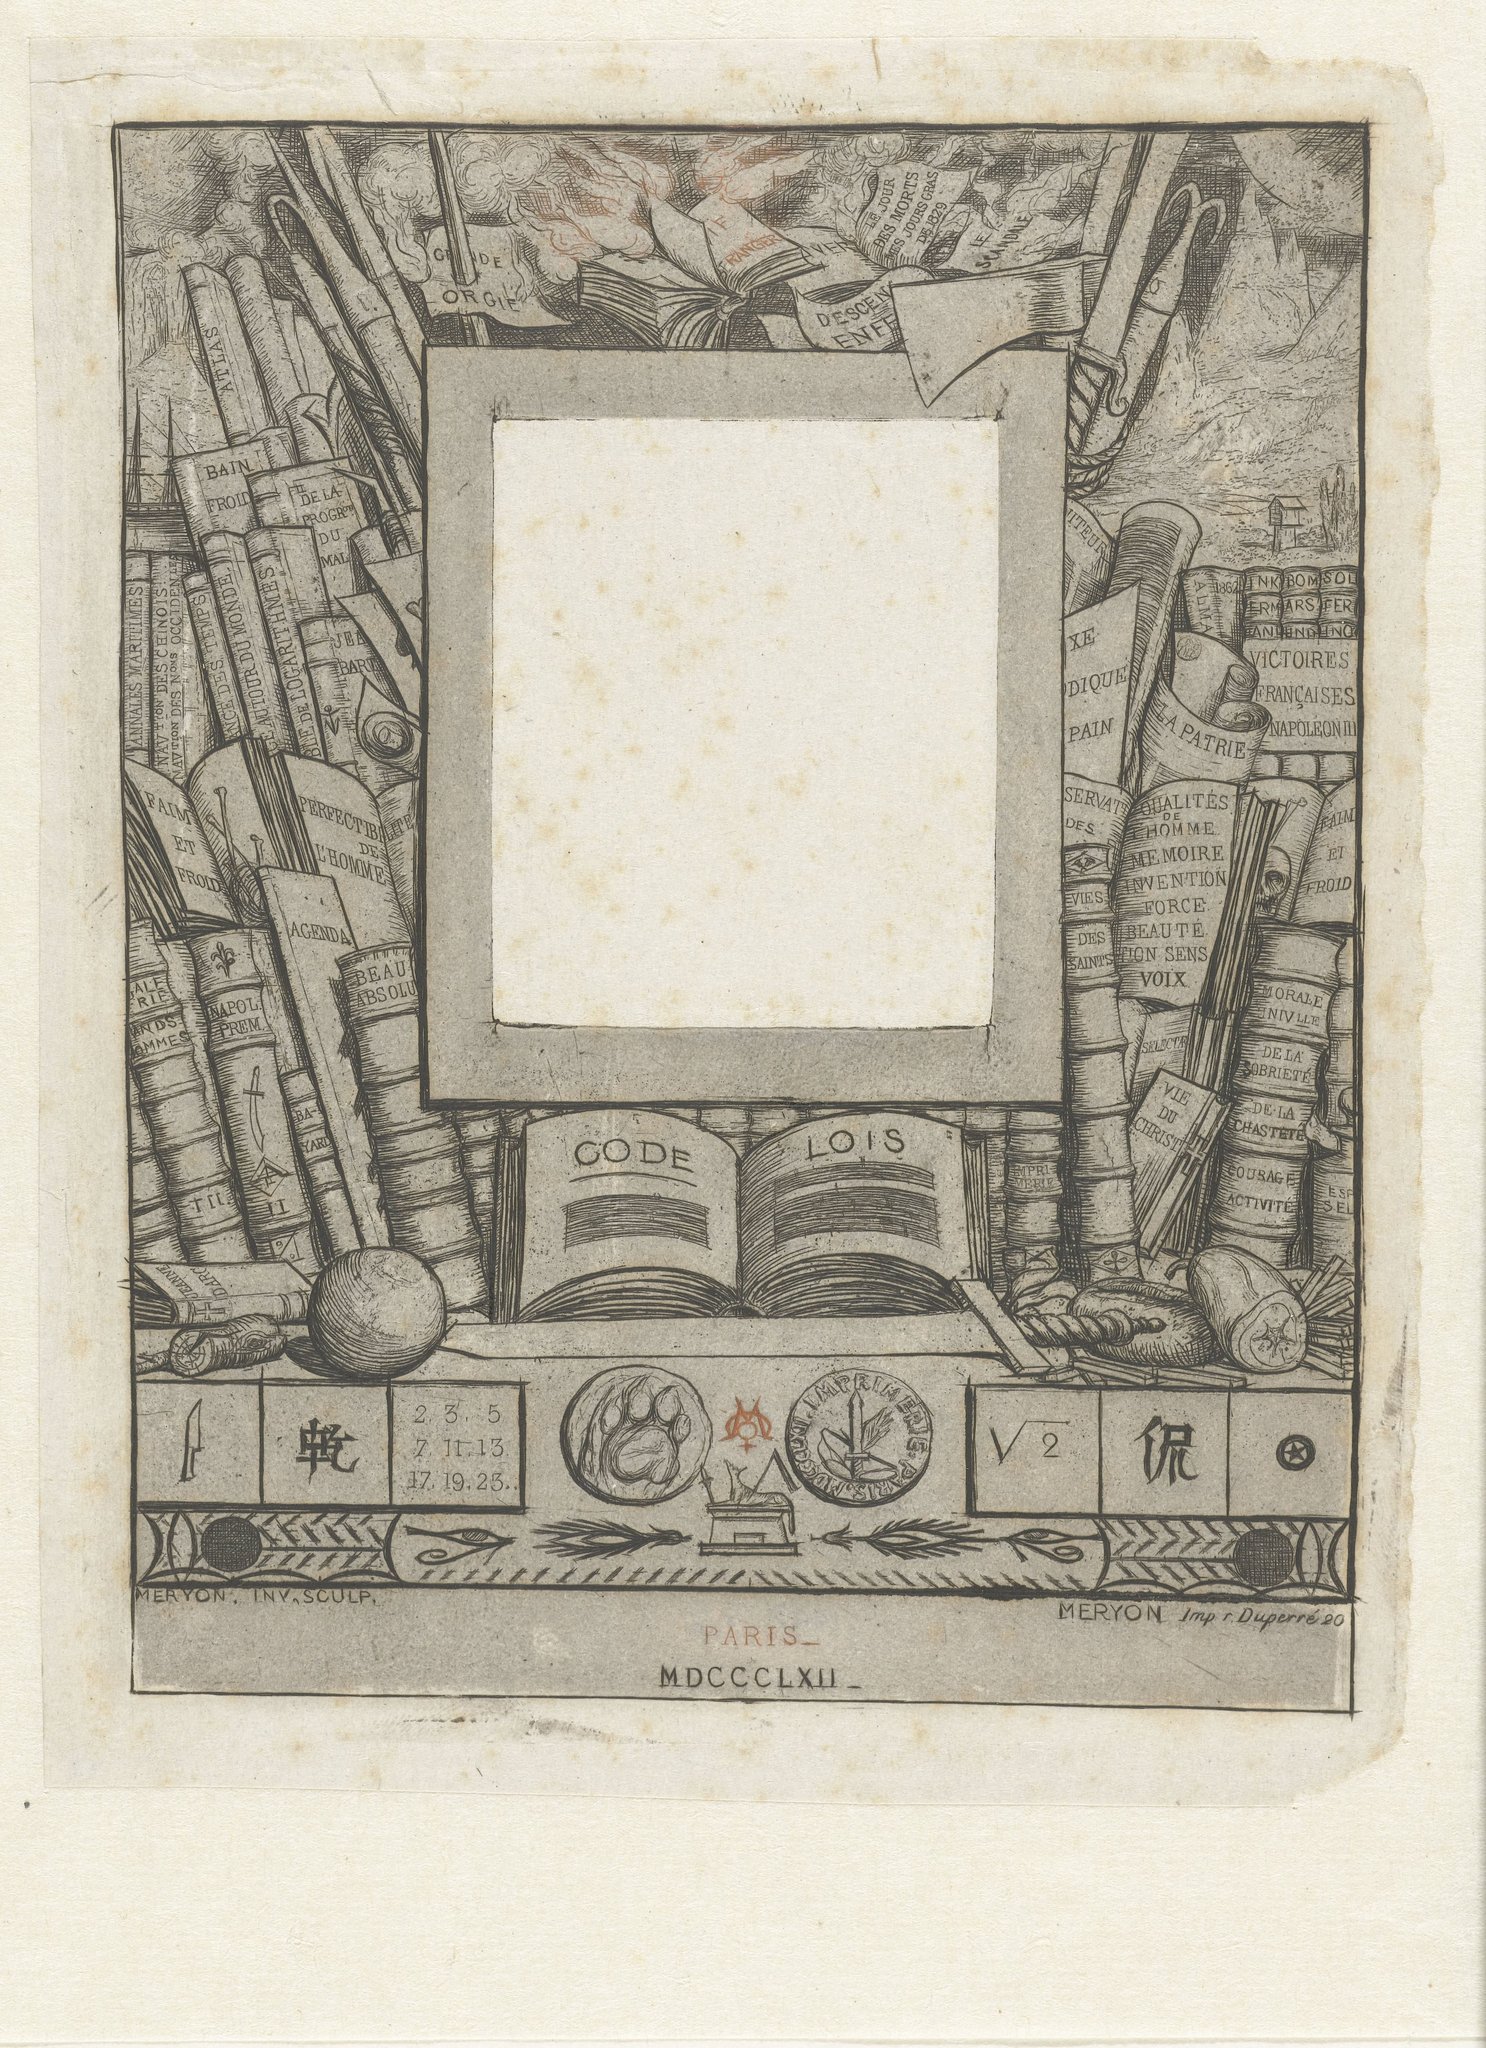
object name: print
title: Omlijsting voor portret van Armand Guéraud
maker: charles meryon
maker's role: print maker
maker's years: 1821-1868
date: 1862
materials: paper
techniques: drypoint, etching, intaglio, lithography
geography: paris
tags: book, tools, implements of printer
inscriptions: collector's mark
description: Omlijsting met allegorische voorstelling van de uitvinding en toepassing van de drukkunst. Boeken met titels op de banden en drukkersgereedschappen staan op elkaar gestapeld ronde een leeg kader. Onder het kader, bedoeld voor het portret van de drukker Armand Guéraud, ligt een wetboek met een zwaard. In een band onderaan staan onder andere Chinese karakters en hierogliefen. Meryon nam veel moeite voor de uitwerking van de omlijsting, hij vervaardigde veertien staten en wijzigde steeds de titels op de boeken naast nog andere details. Opvallend zijn enkele rode accenten waar de kunstnaar mee experimenteerde.